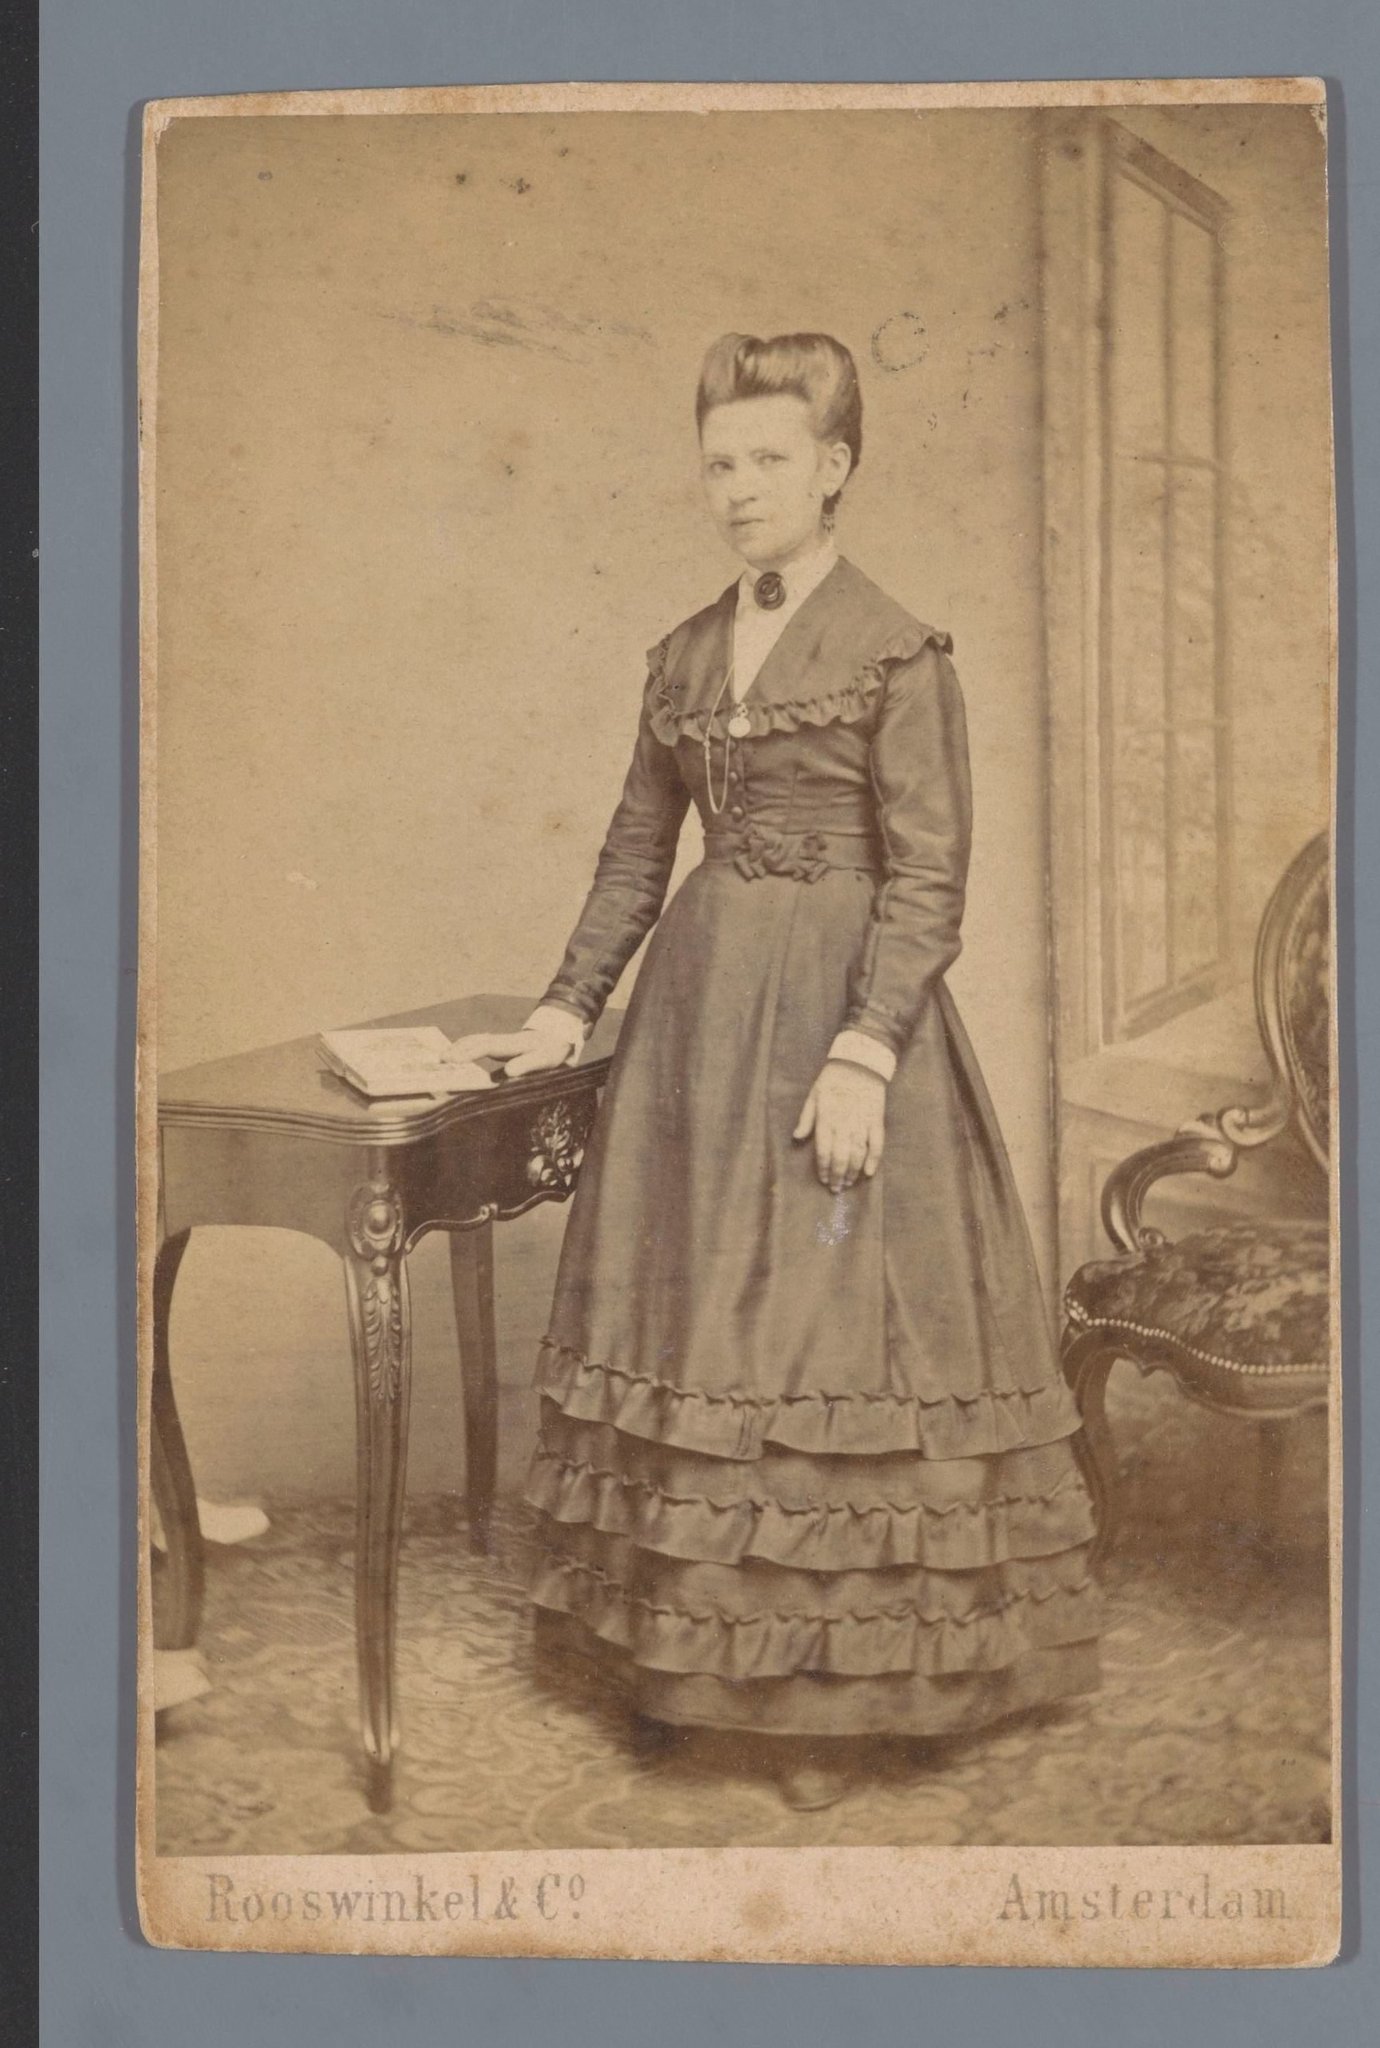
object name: photograph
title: Portret van een vrouw met een boek bij een tafel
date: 1868-1906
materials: cardboard, paper, photographic support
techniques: albumen print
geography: amsterdam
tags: historical persons not known by name - bb - woman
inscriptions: inscription: ‘Anni apreciada amiga la Senorita / San Martin / Beatris M. de Jer[...]’, signature and date: ‘COURRET HERMANOS Fotógr LIMA. Verso gedrukt: COURRET HERMANOS / Fotógrafos / Calle mercaderes (Union) No. 197 / LIMA’